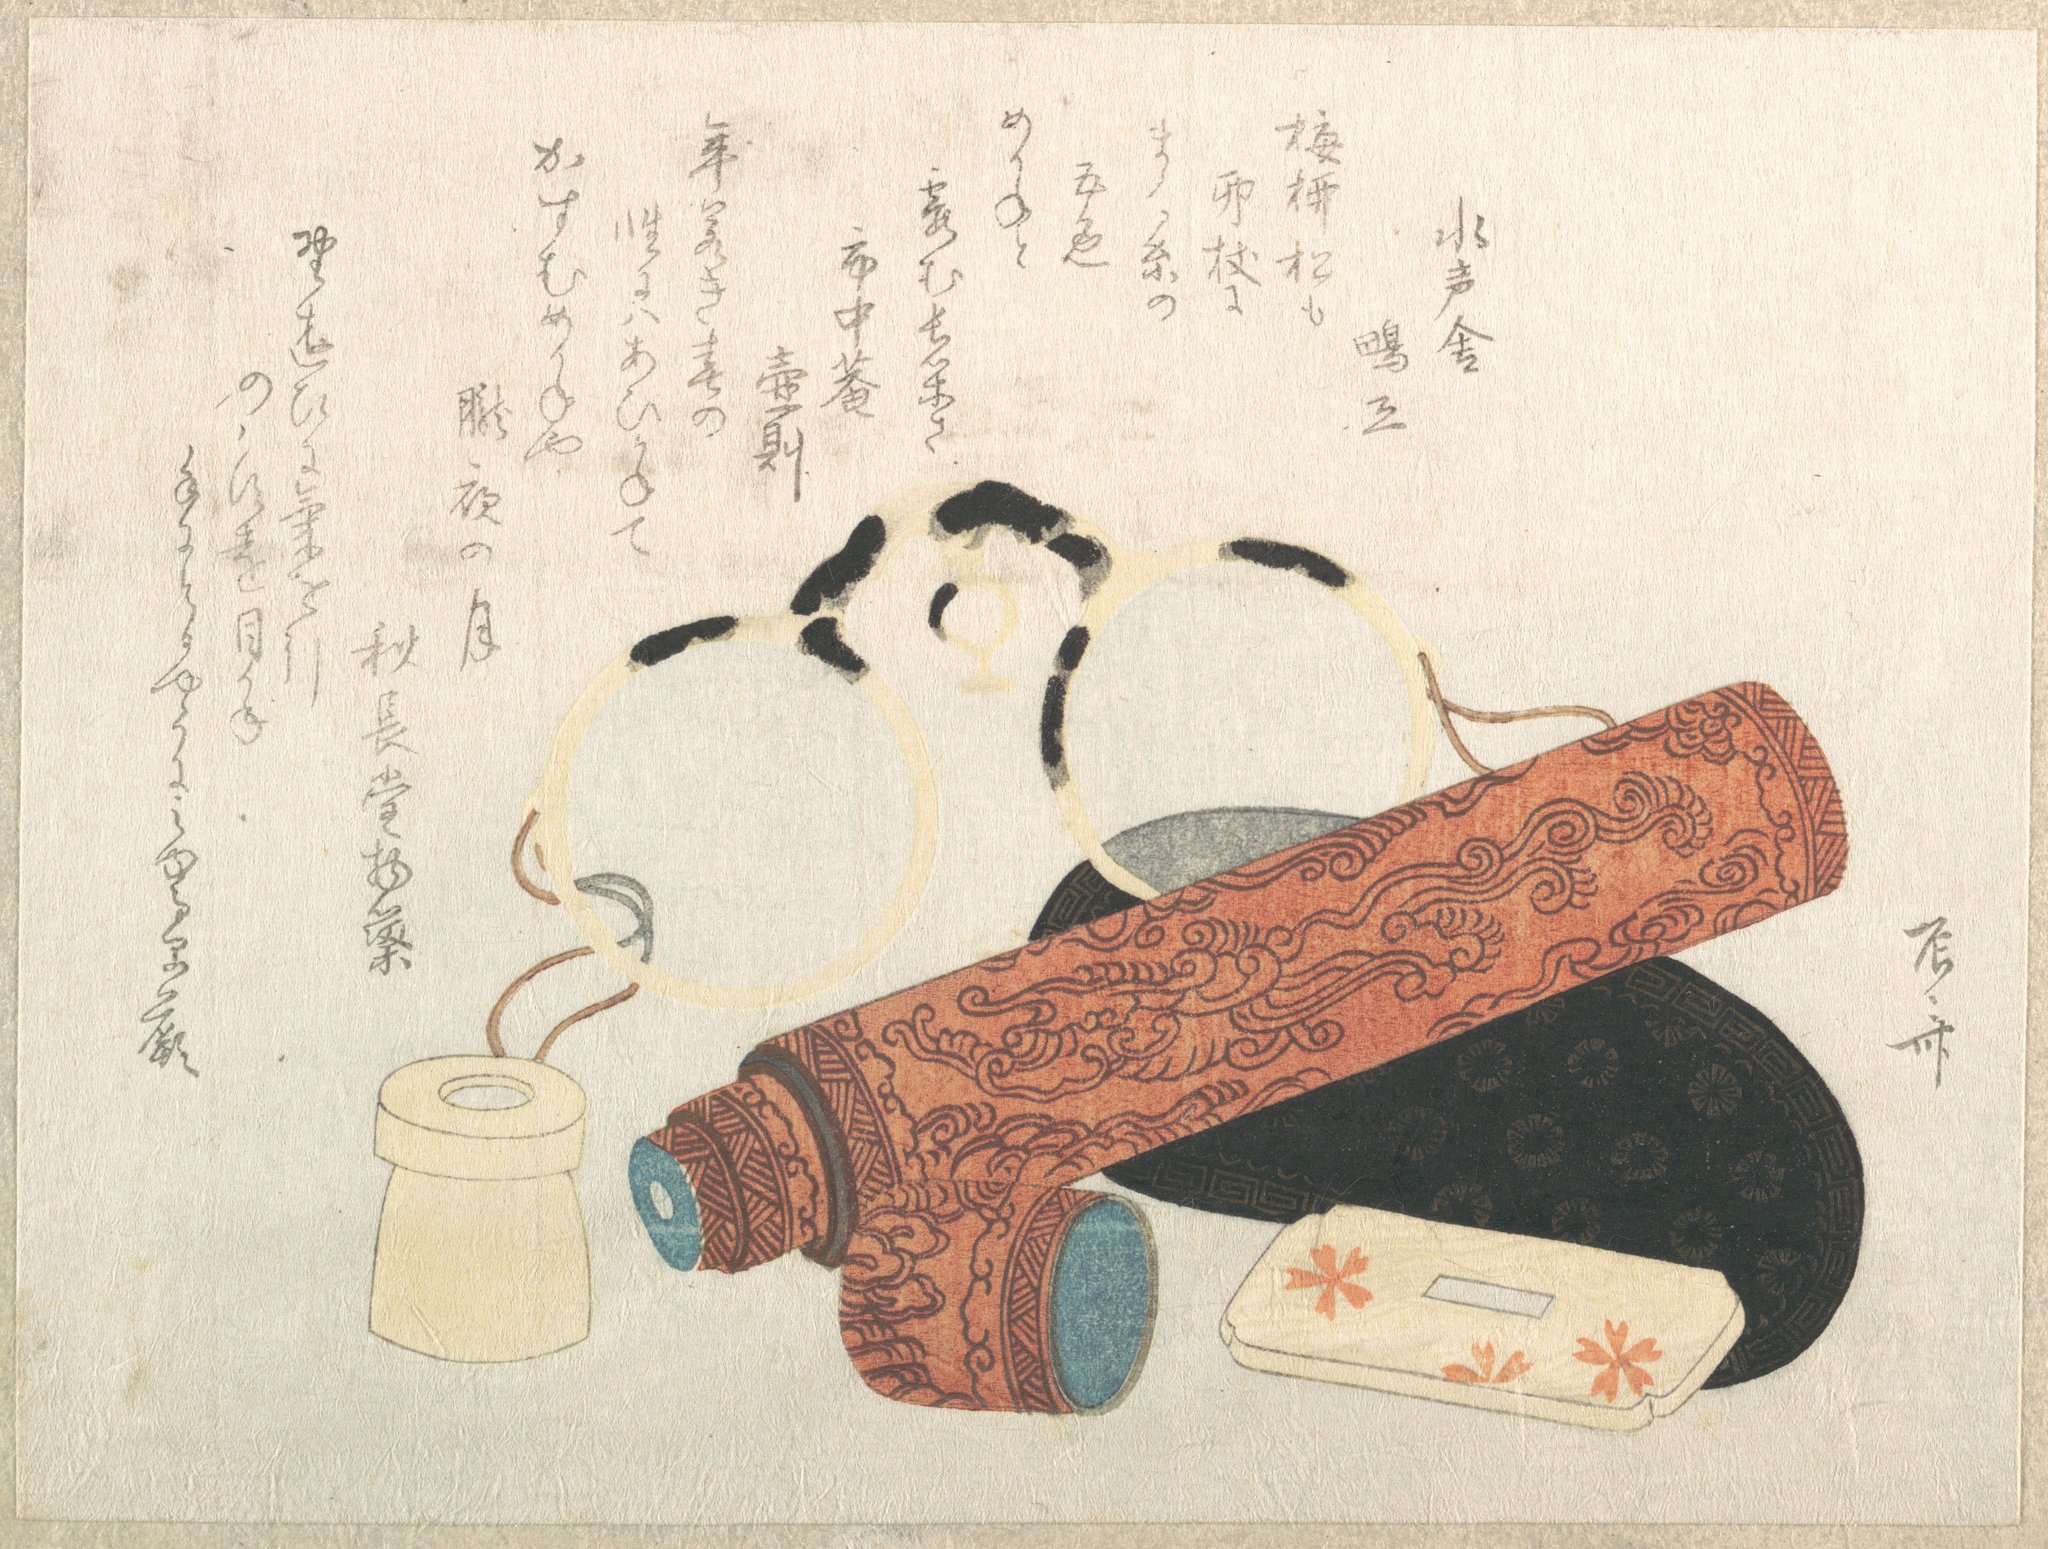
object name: woodblock print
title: Spectacles and Telescope with Cases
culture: japanese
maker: ryūryūkyo shinsai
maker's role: artist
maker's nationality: japanese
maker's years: 1799-1823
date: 1801-1900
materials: ink, paper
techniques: surimono, woodblock print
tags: telescopes